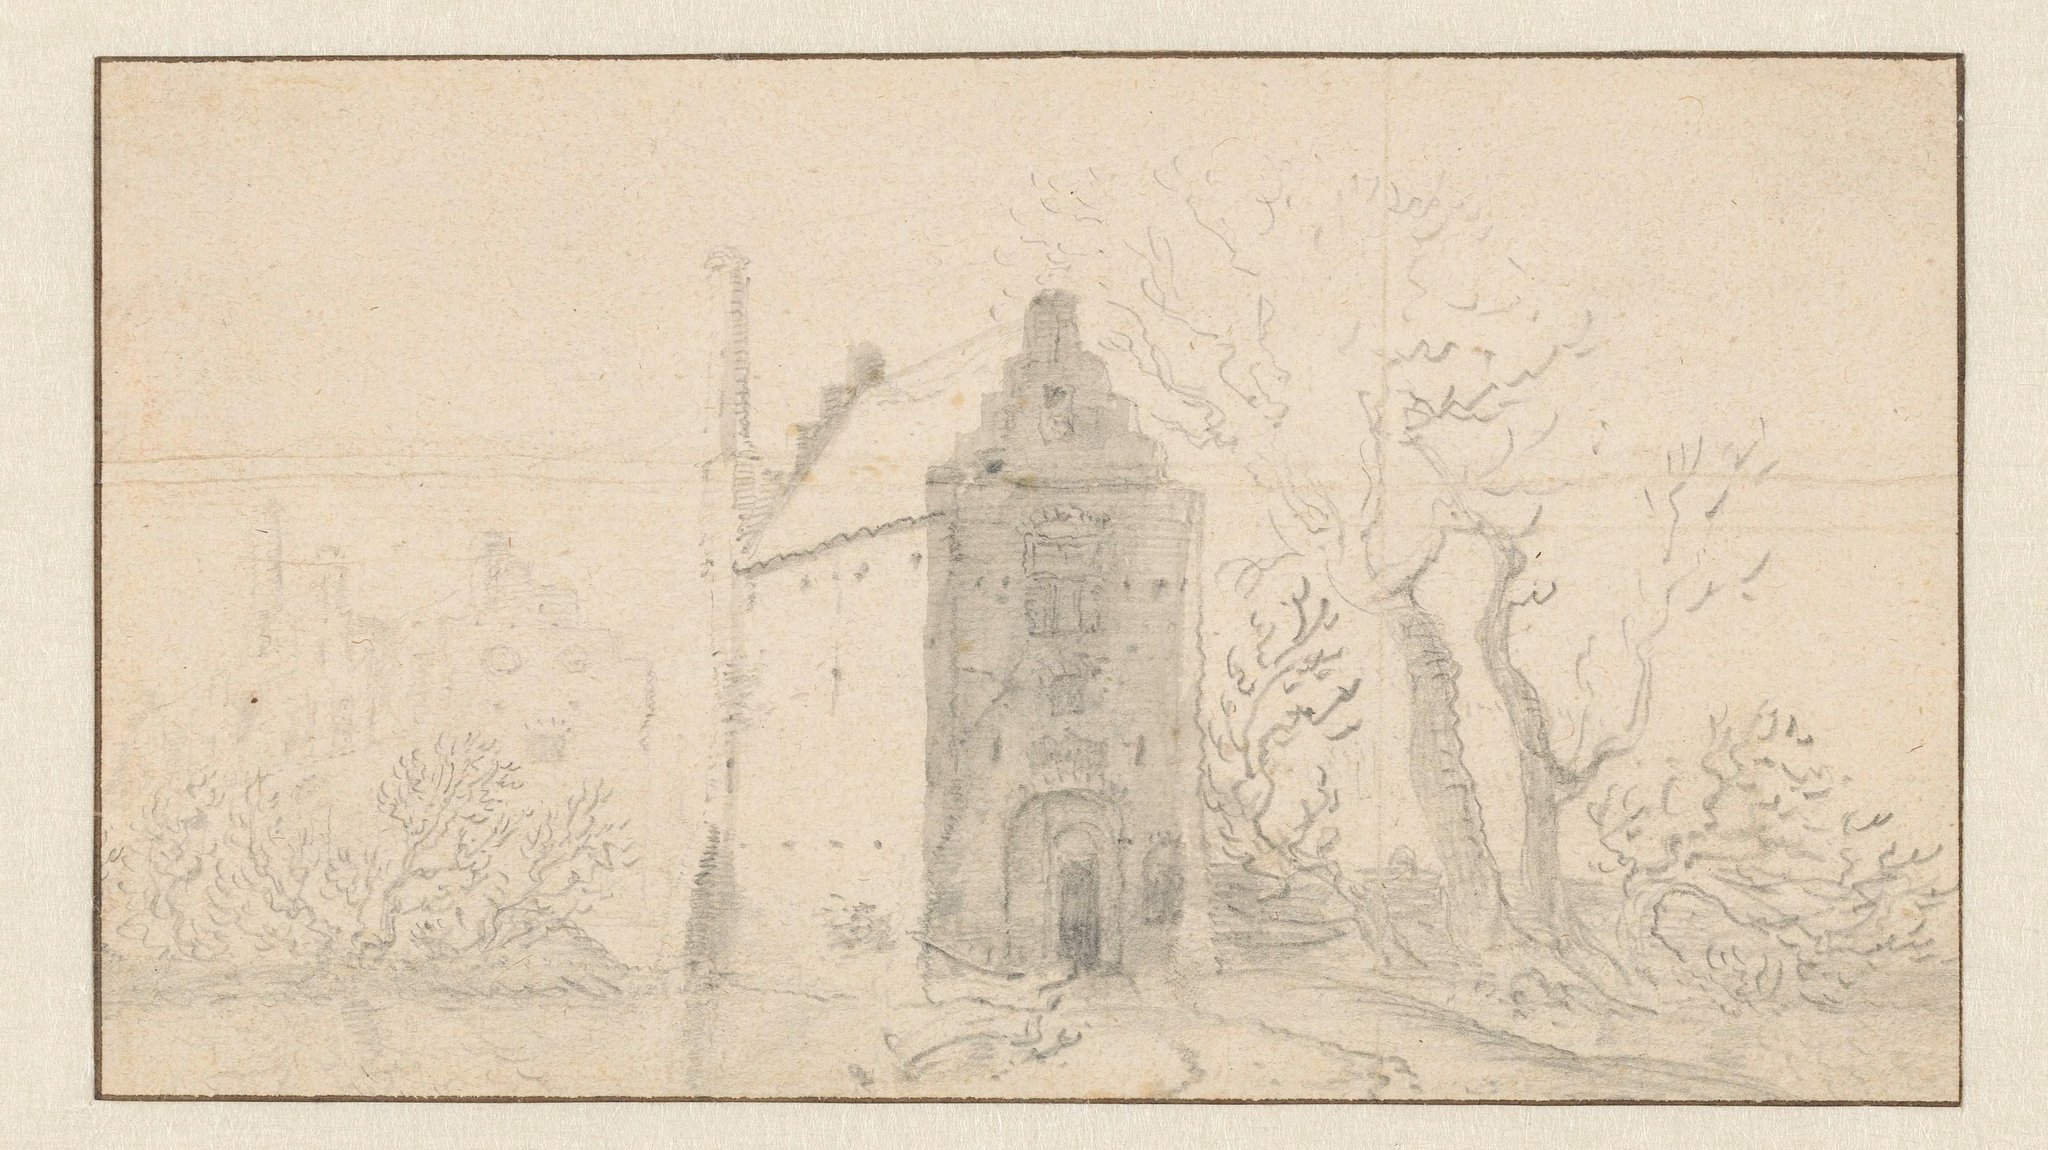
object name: drawing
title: 't Huys te Voorburg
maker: jan abrahamsz. beerstraten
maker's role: draughtsman, painter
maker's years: 1622-1666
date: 1600-1699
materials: paper, pencil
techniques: brush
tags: ruin of a dwelling, house, castle, etc., country-house, voorburg